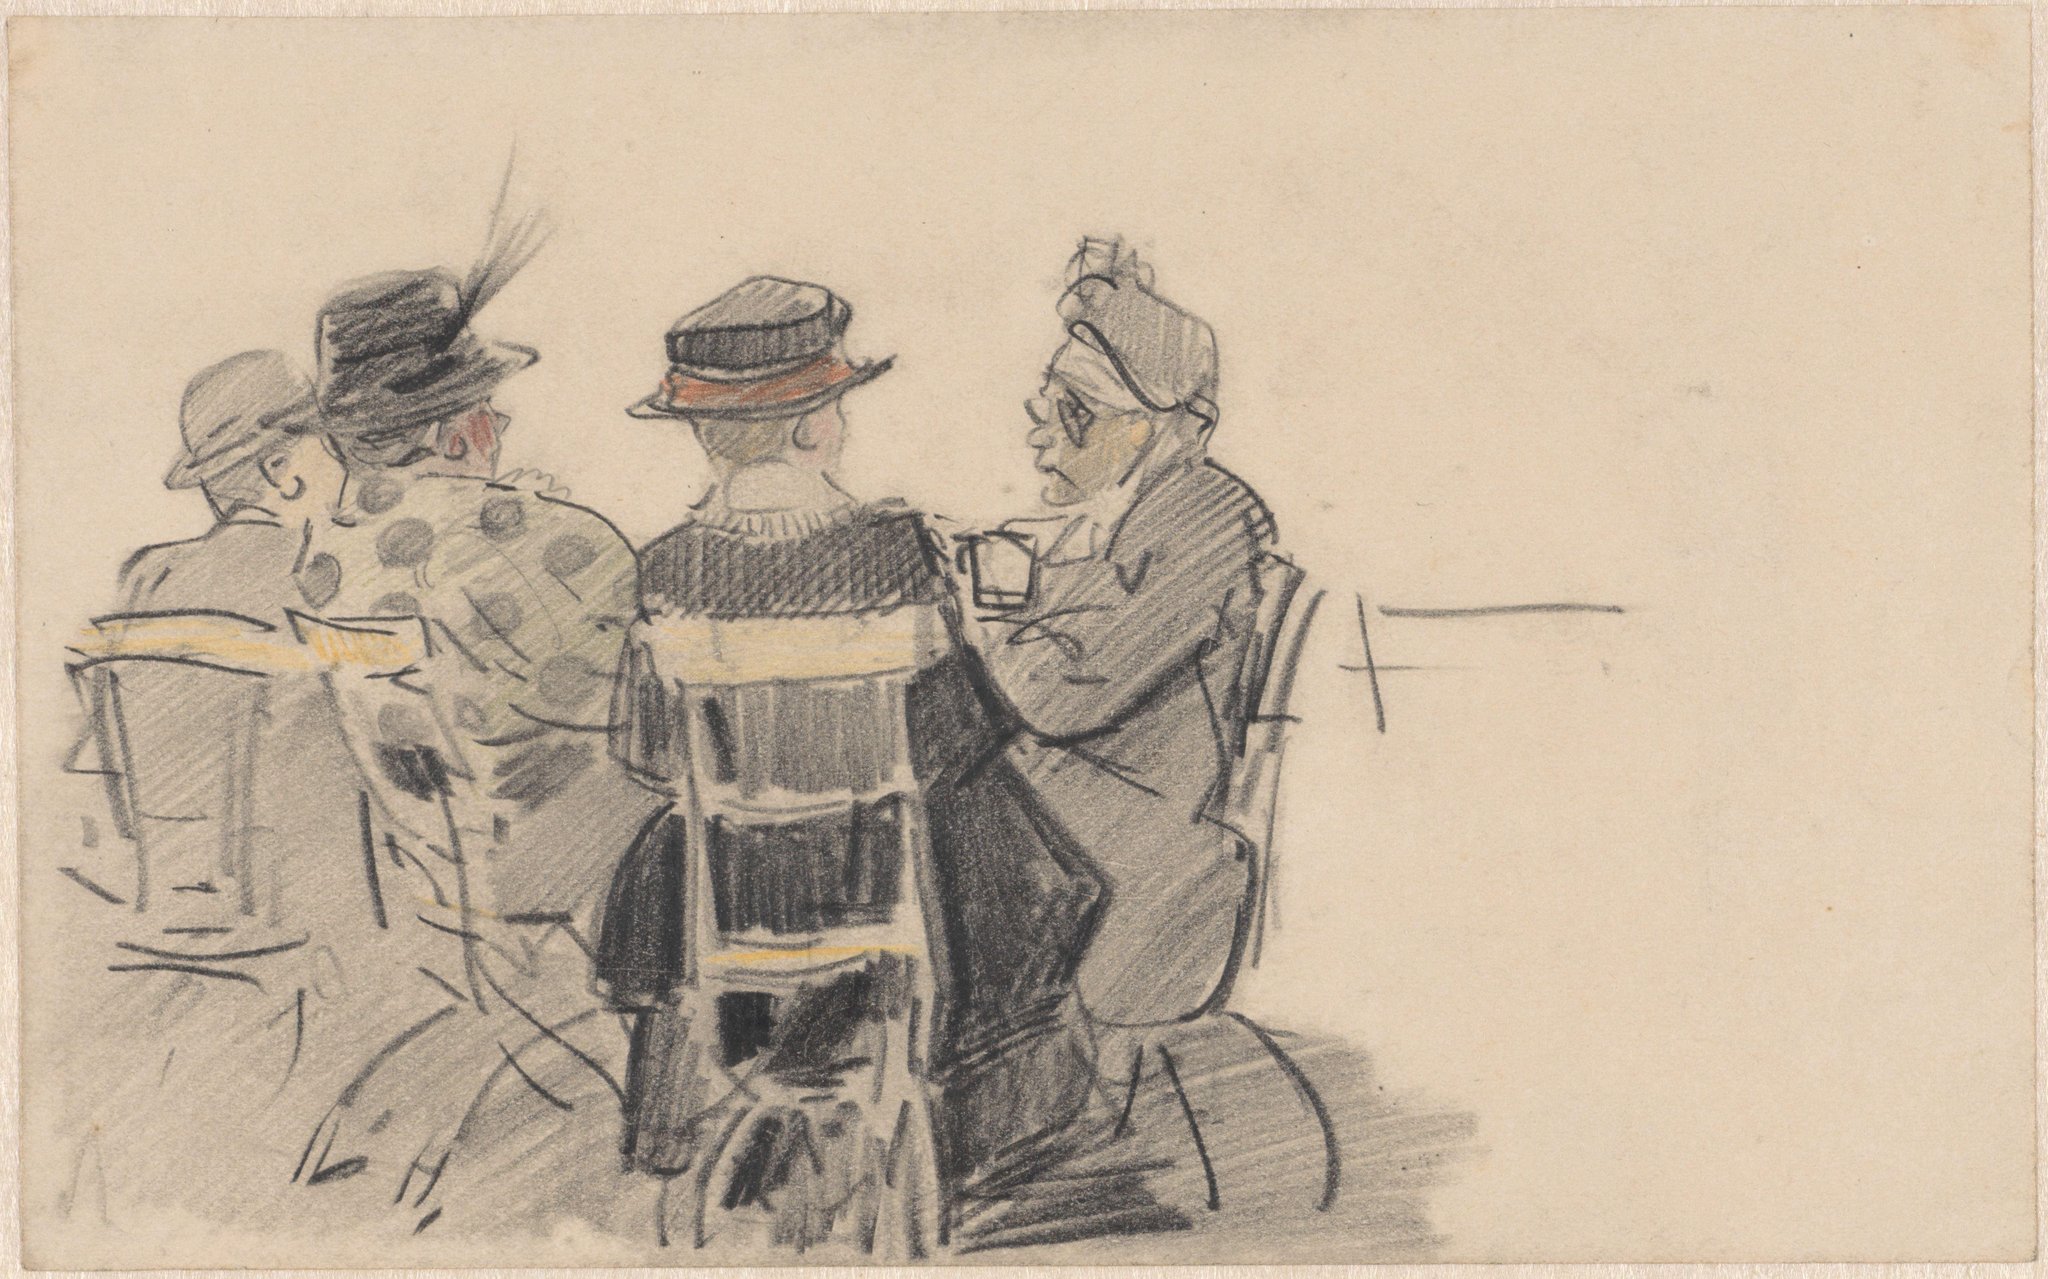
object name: drawing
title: Theekransje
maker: herman moerkerk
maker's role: draughtsman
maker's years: 1879-1949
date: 1889-1944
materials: paper, pencil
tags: cup of tea (+ taking (particular) foodstuffs: eating, drinking, smoking, chewing, etc.)